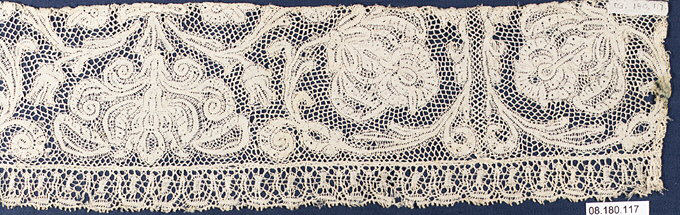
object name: fragment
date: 1667-1700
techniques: lace